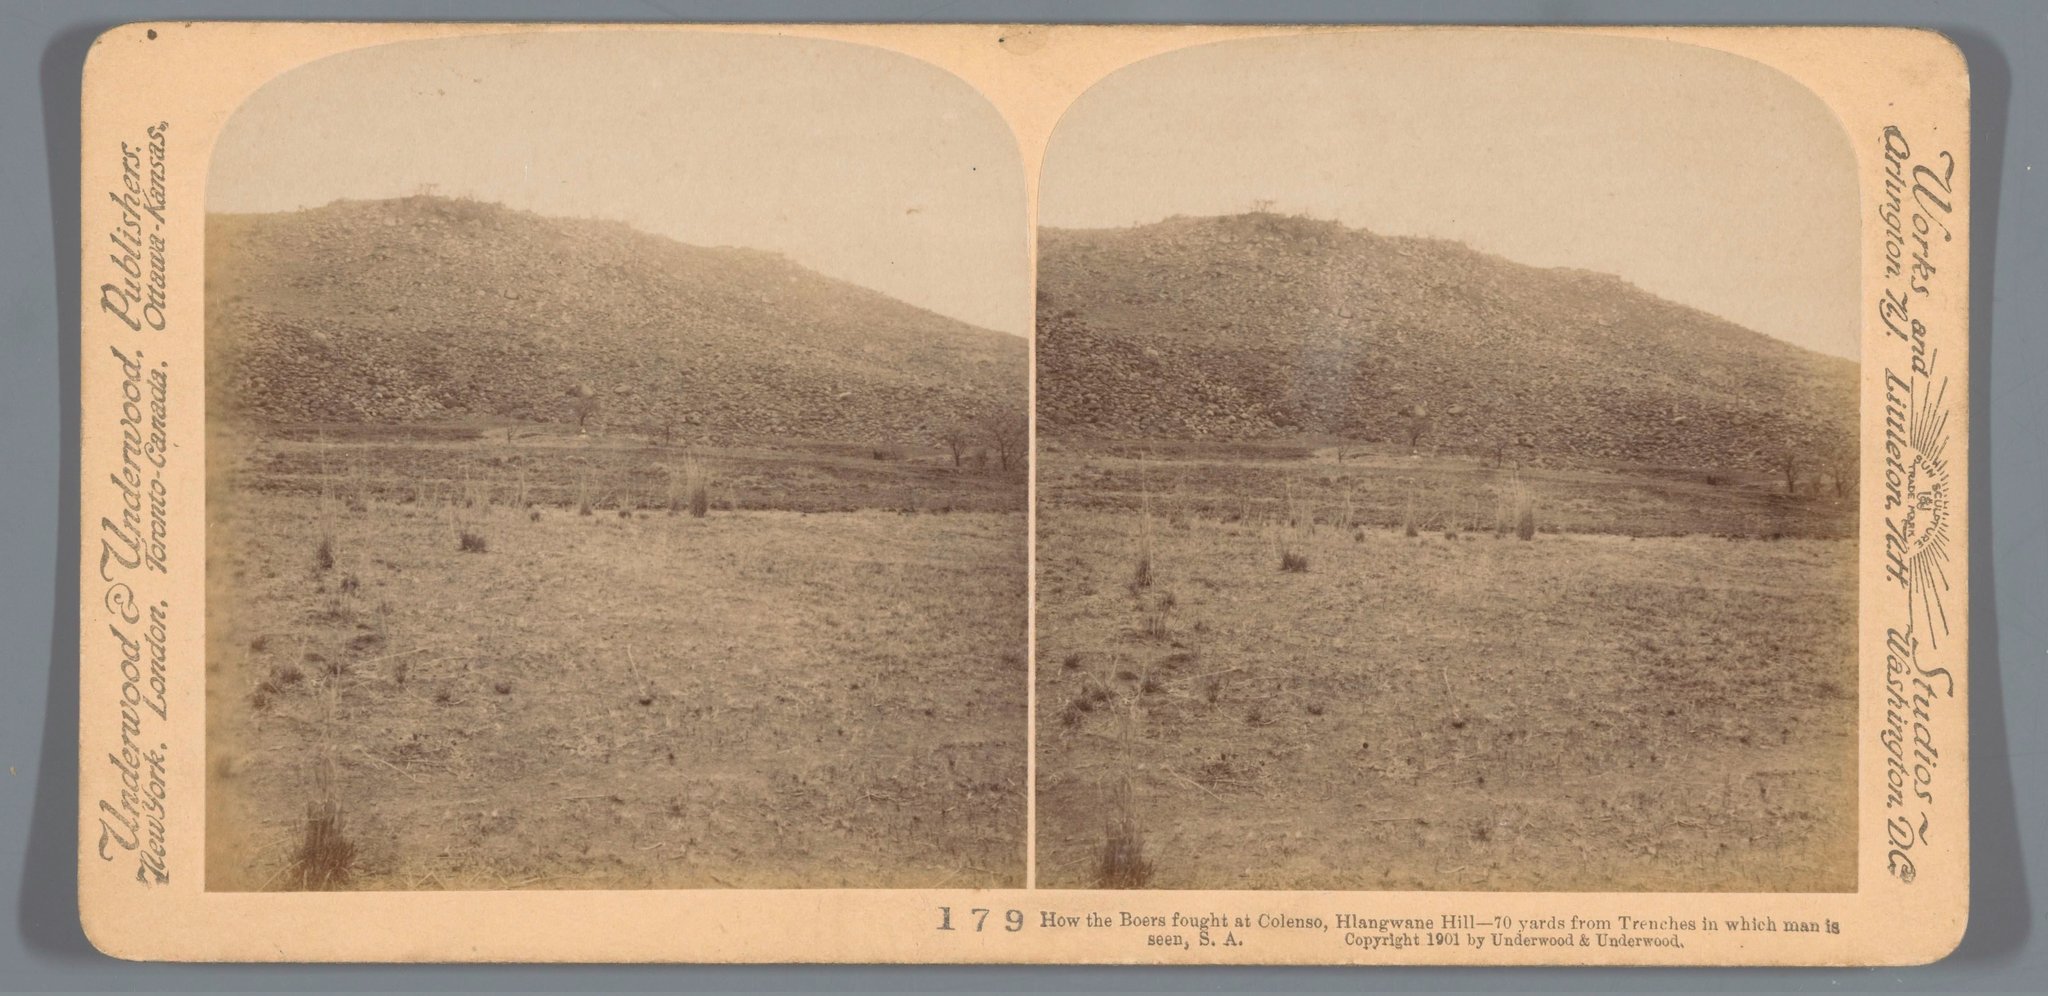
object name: stereograph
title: How the Boers fought at Colenso - Hlangwane Hill - 70 yards from trenches in which man is seen, S.A.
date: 1901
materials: cardboard, photographic support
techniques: albumen print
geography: south africa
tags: low hill country, trenches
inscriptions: name: ‘Works and Studios Sun Sculpture trade mark Arlington N.J. Littleton N.H. Washington D.C.’, number: ‘179’